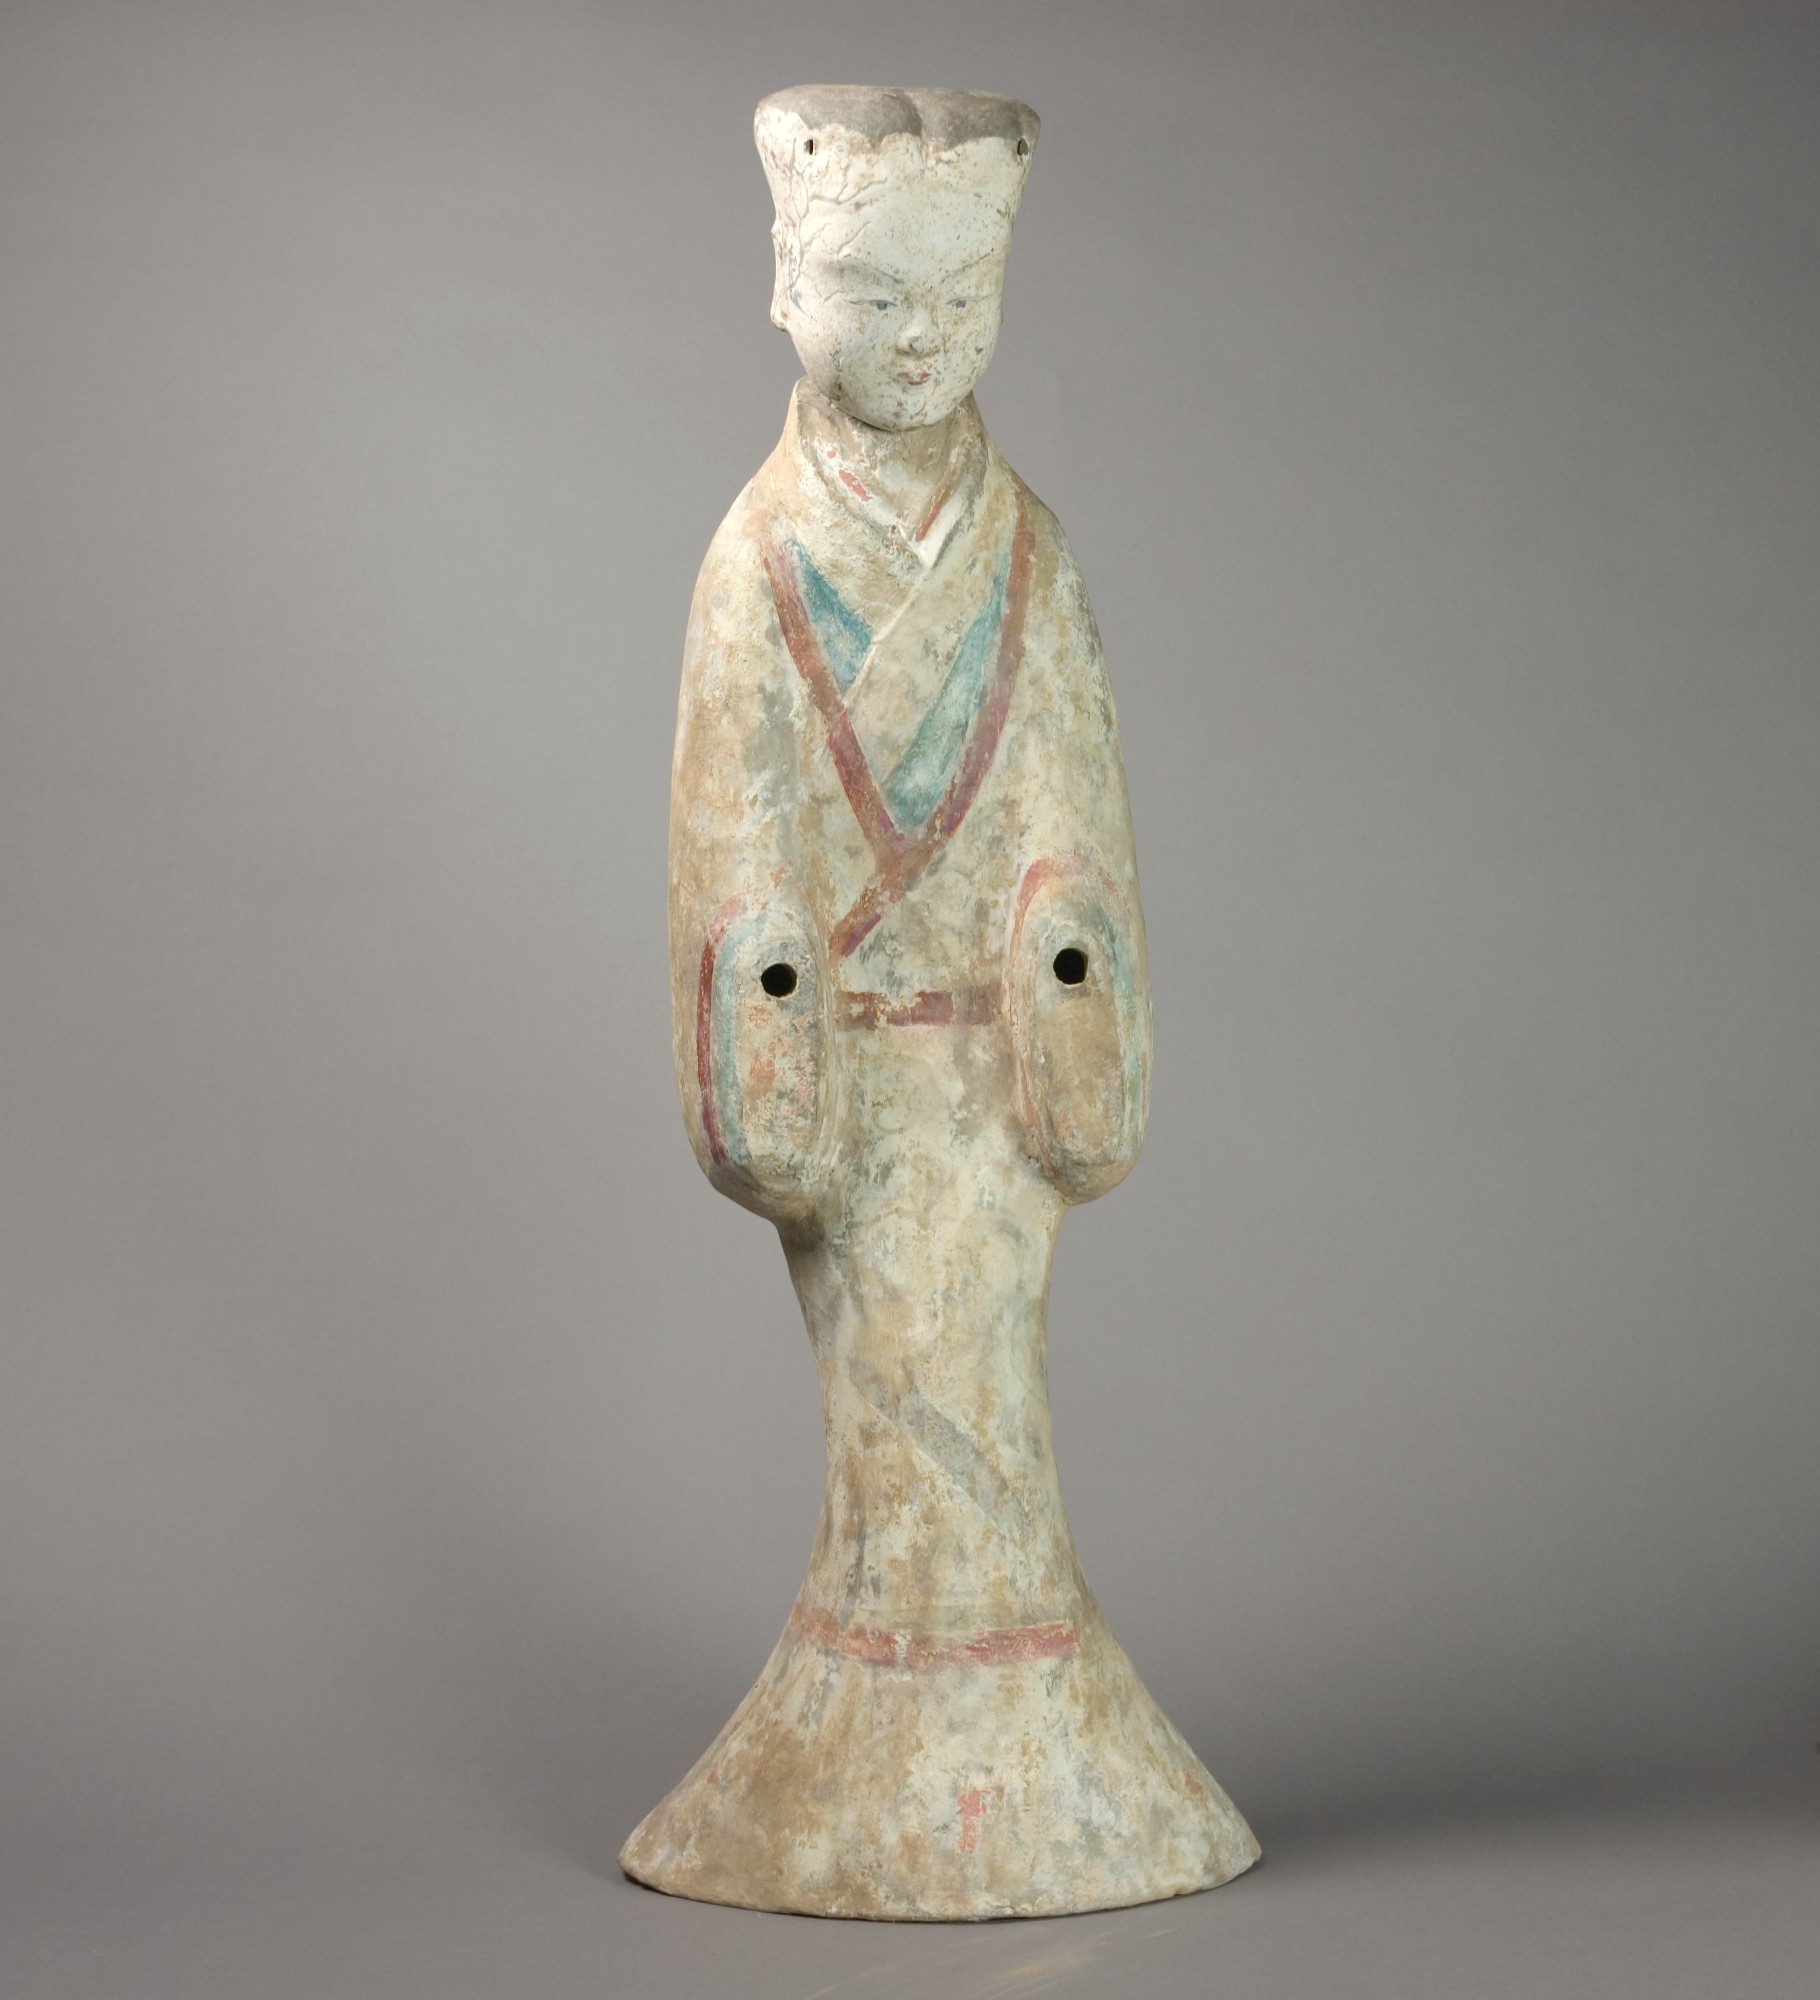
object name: figure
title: Large Figure of a Lady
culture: chinese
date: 206 BCE-8 CE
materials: earthenware, pigment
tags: women